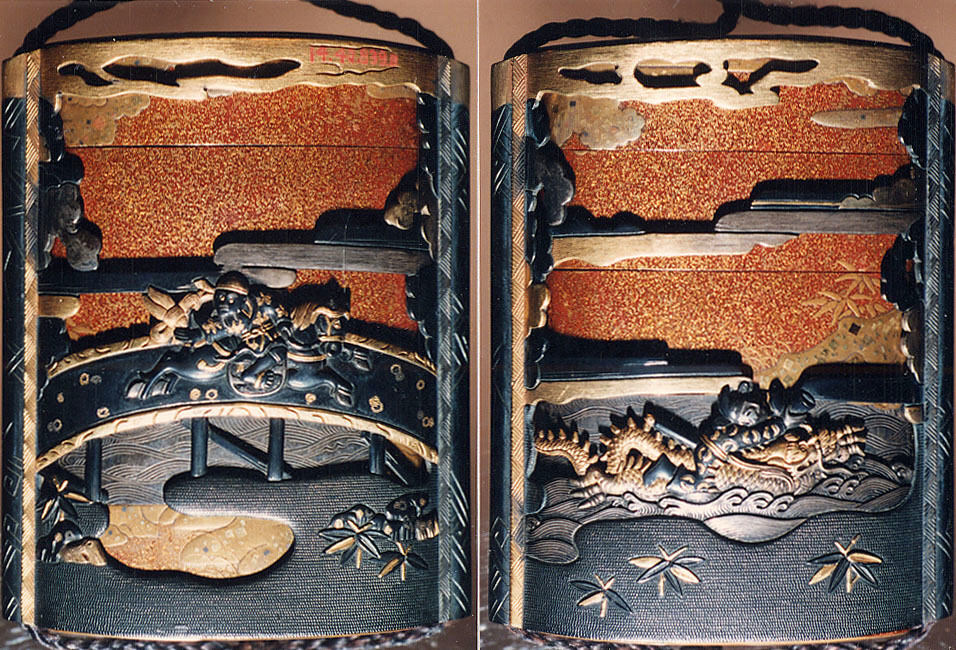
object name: inrō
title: Case (Inrō) with Design of Chōryō and Kōsekikō with Plants, Waves and Clouds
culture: japanese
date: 1701-1900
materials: lacquer, metal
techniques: fundame, relief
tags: bridges,men,dragons,horses